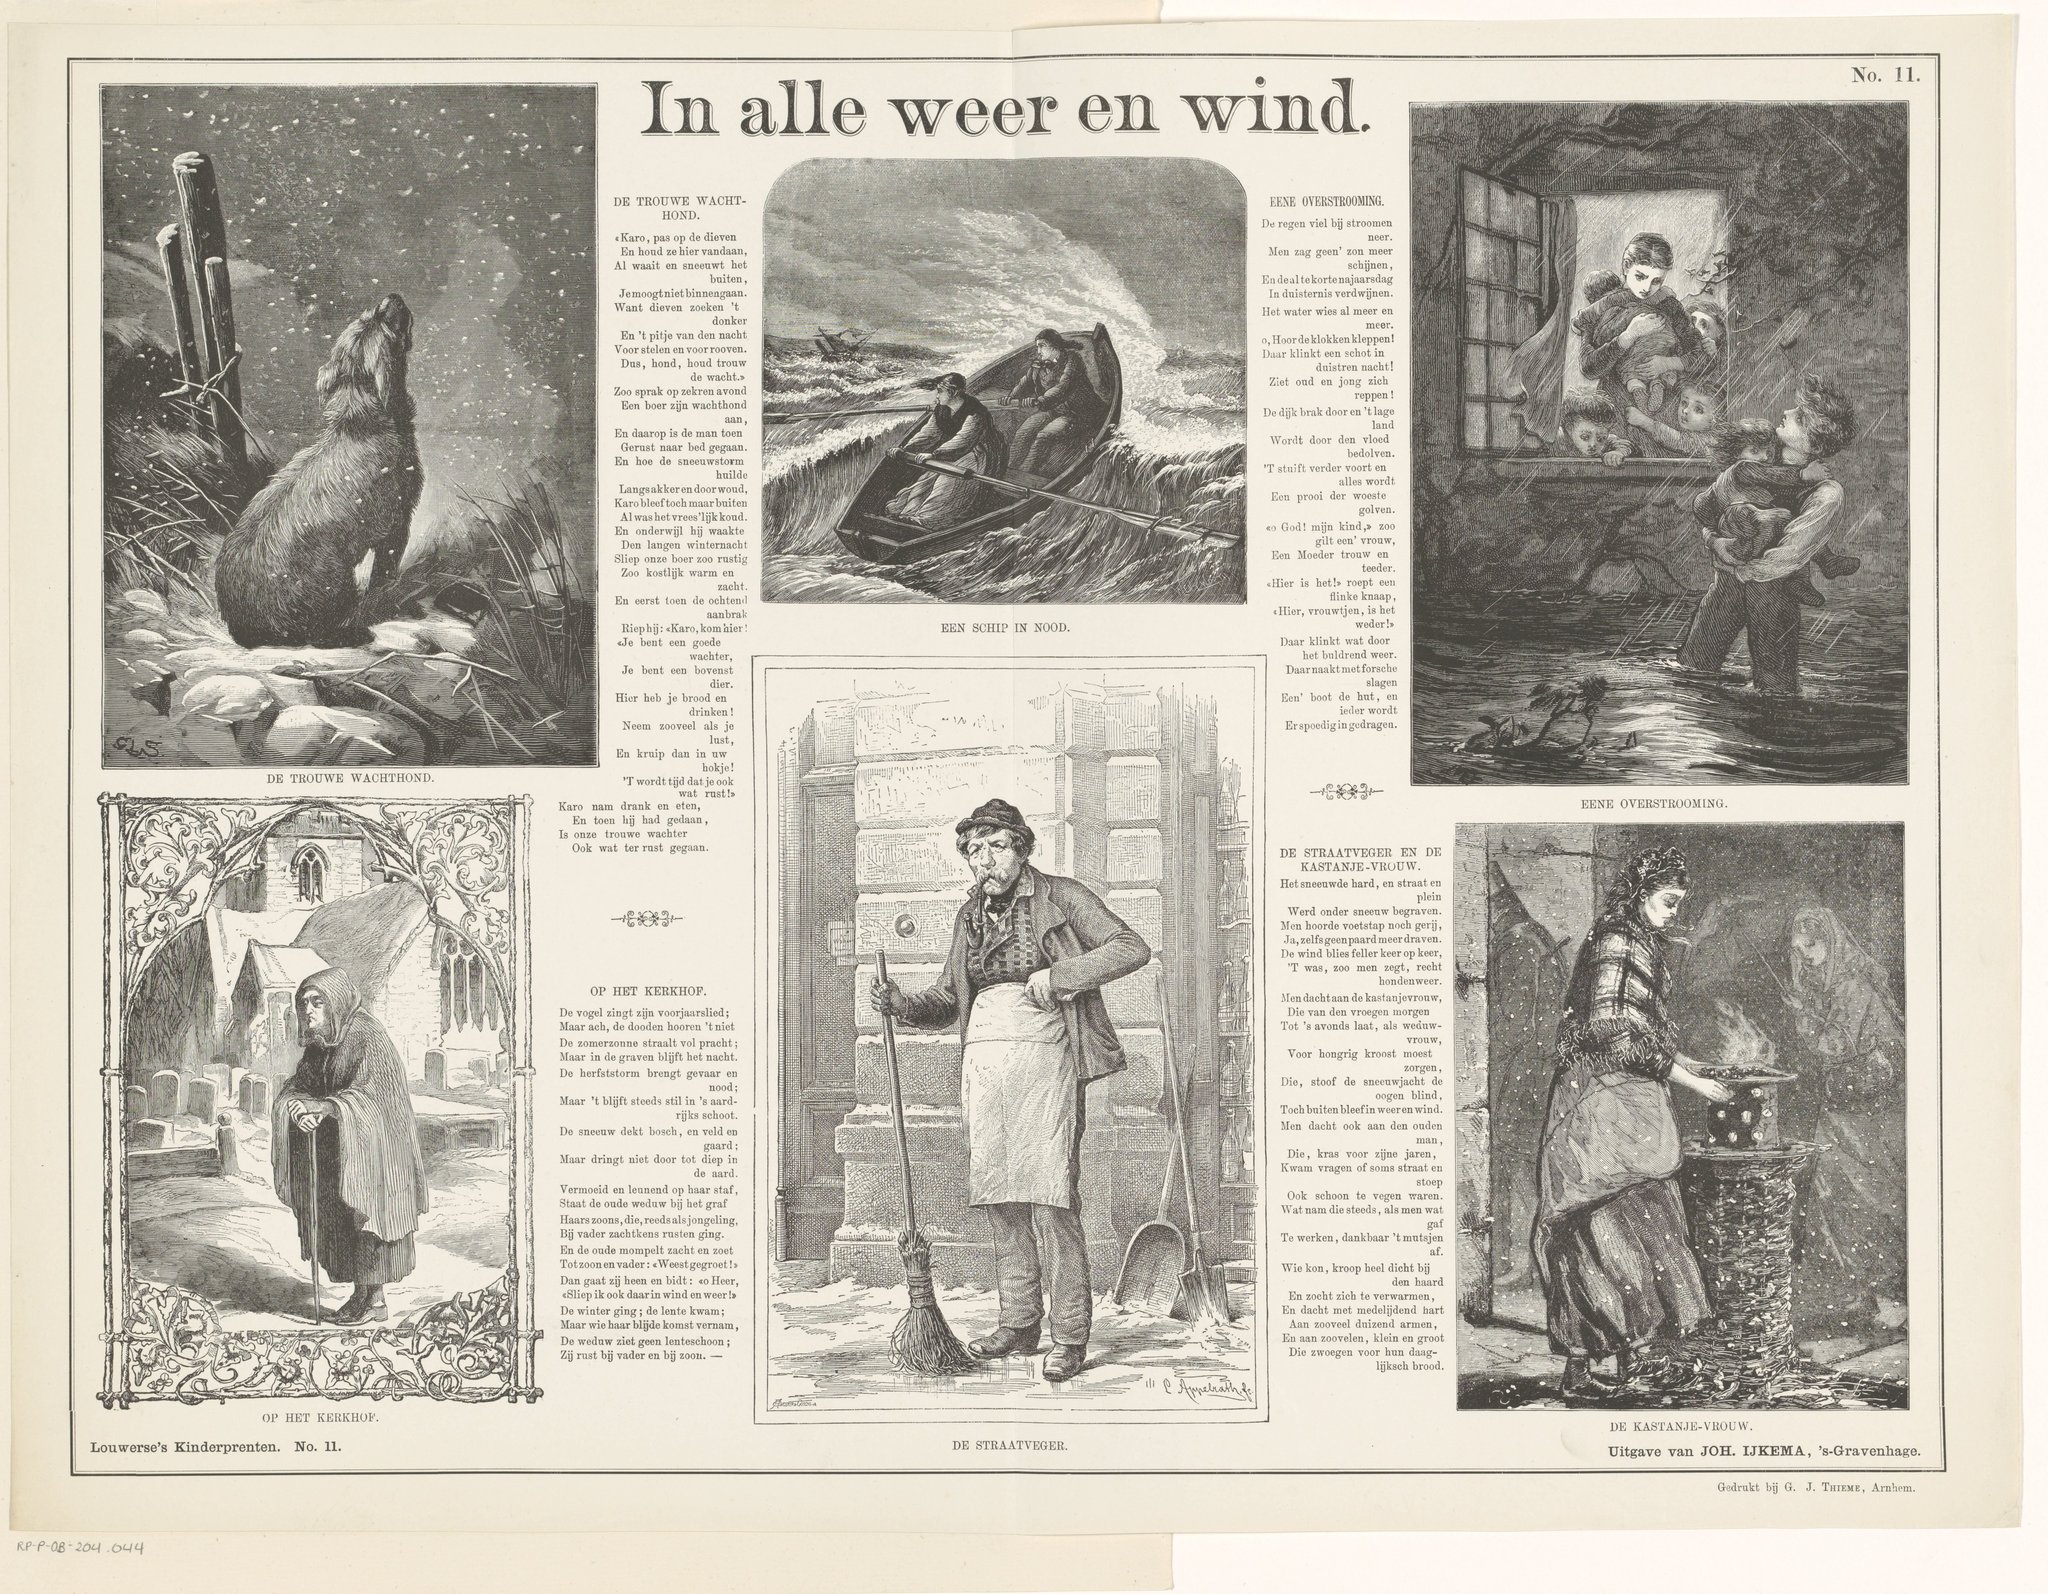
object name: popular print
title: In alle weer en wind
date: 1882-1905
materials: paper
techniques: letterpress printing, printing block, engraving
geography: the hague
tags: rain, snow, storm at sea, bad weather, dog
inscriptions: collector's mark: Lugt 2760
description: Blad met 6 voorstellingen van een hond en mensen in verschillende weersomstandigheden. Tussen de afbeeldingen versjes in boekdruk. Genummerd rechtsboven en linksonder: No. 11.